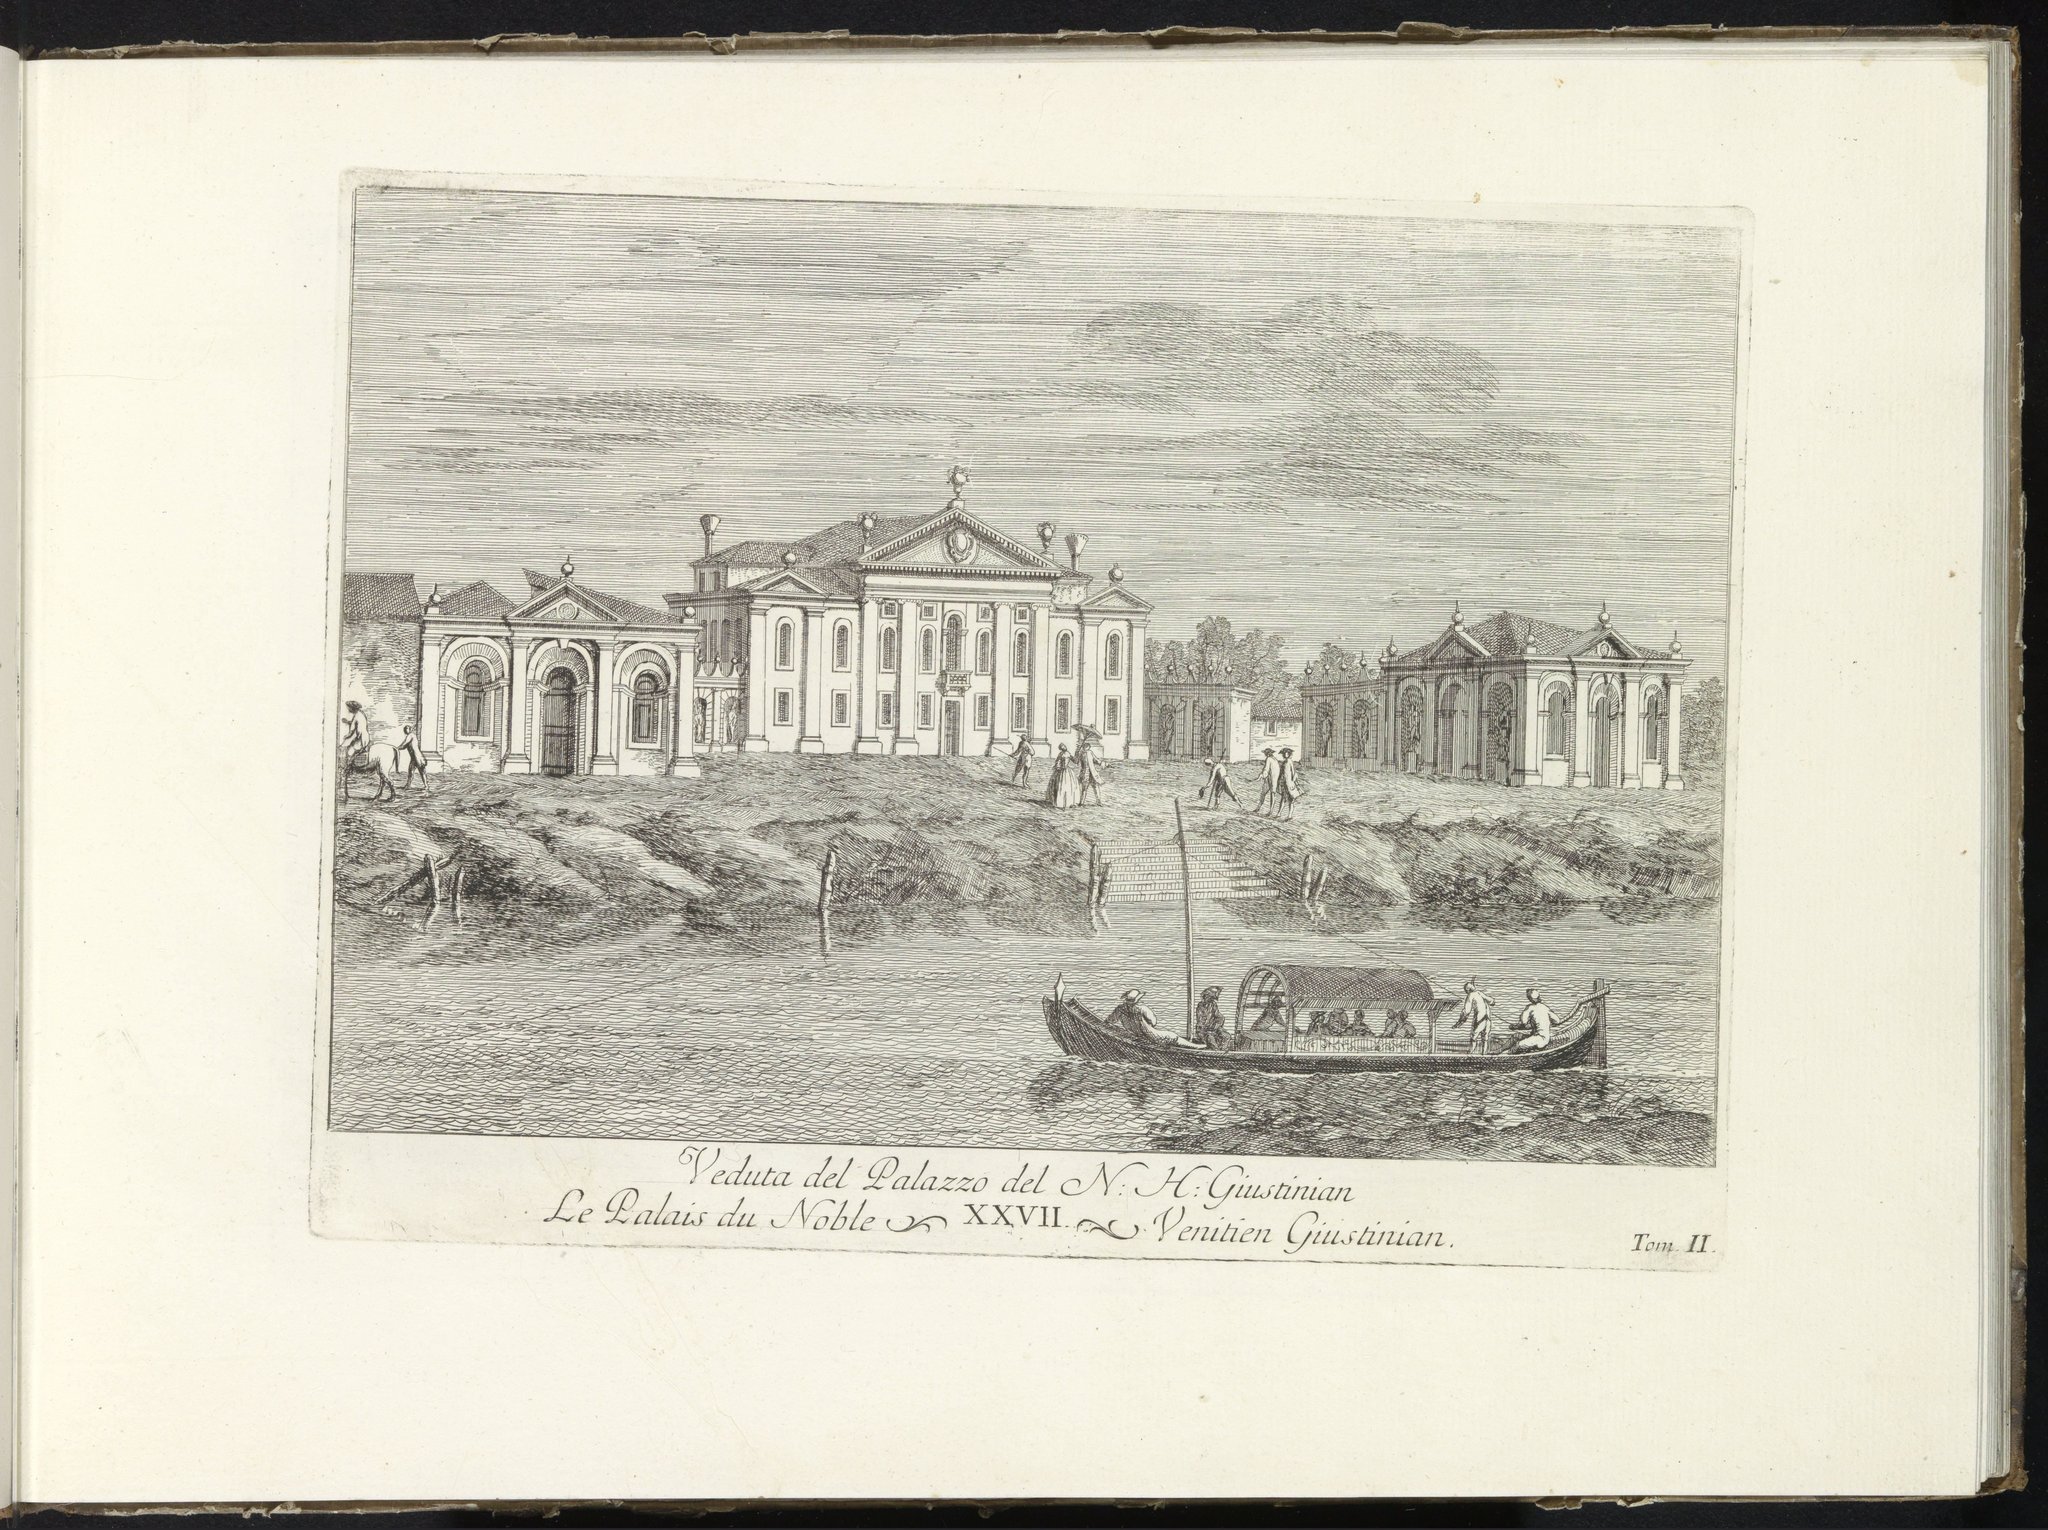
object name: print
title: Gezichten op de rivier de Brenta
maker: giovanni francesco costa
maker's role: draughtsman, painter, print maker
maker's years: -1773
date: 1750-1760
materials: paper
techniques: etching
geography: venice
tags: river, hôtel, i.e. small palace in city, gondola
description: Gezicht op Palazzo del N: H: Giustinian aan de rivier de Brenta. Op het water vaart een gondel. Figuren flaneren aan de waterkant. Genummerd midden onder: XXVII en rechtsonder: Tom: II. Deze prent maakt deel uit van een album.